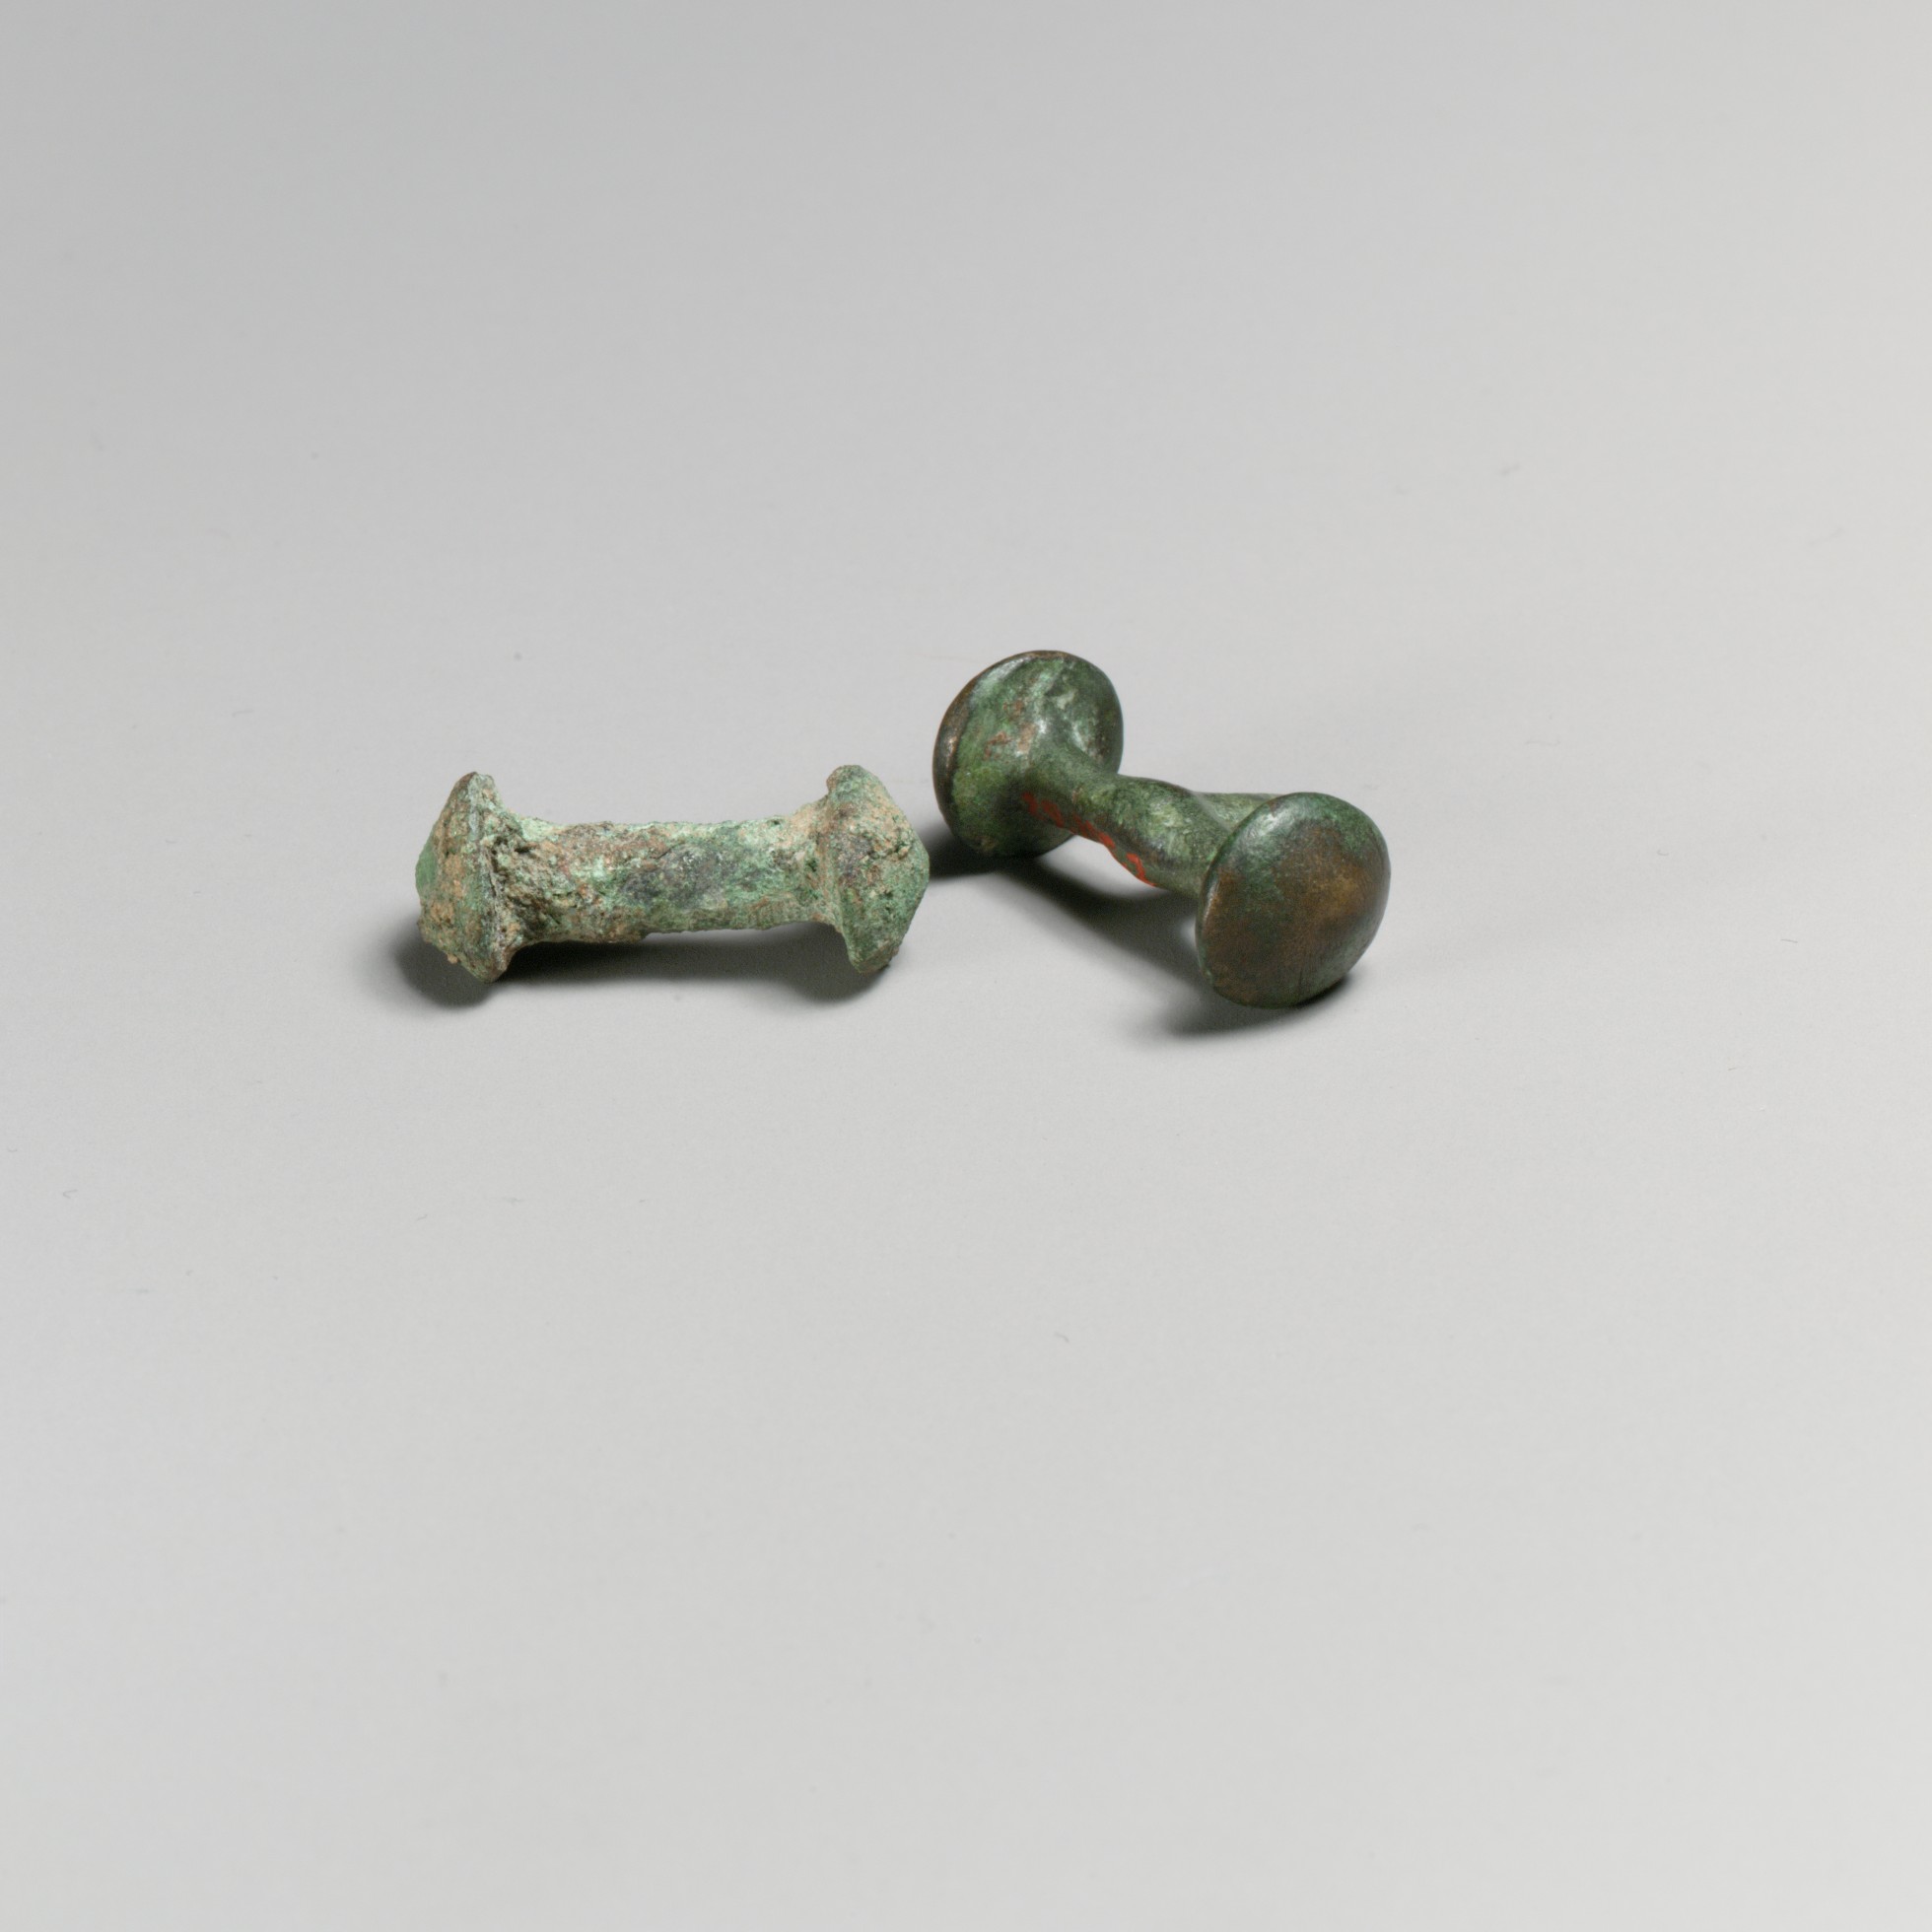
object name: chariot fastening from etruscan biga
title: Chariot fastenings from Etruscan biga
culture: etruscan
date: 900-100 BCE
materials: bronze